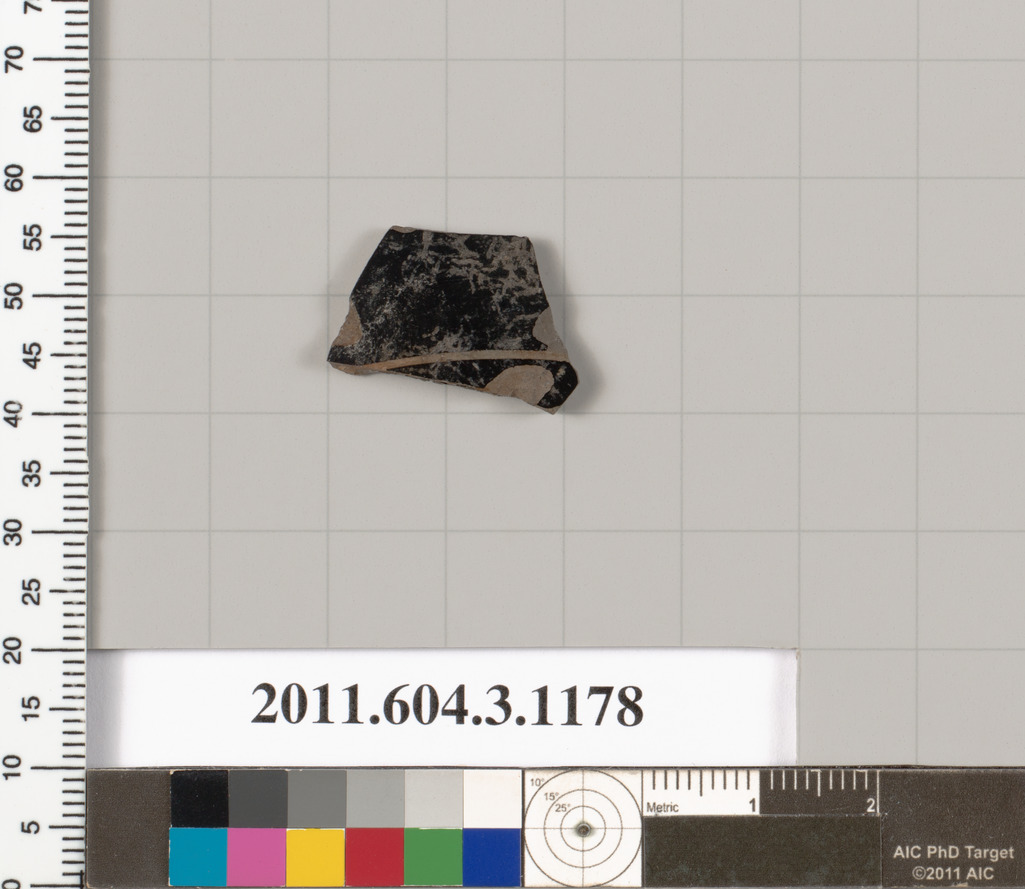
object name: mastoid or kyathos fragment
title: Terracotta fragment of a mastoid (drinking cup with narrow base) or a kyathos (cup-shaped ladle)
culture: greek, attic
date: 534-468 BCE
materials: terracotta